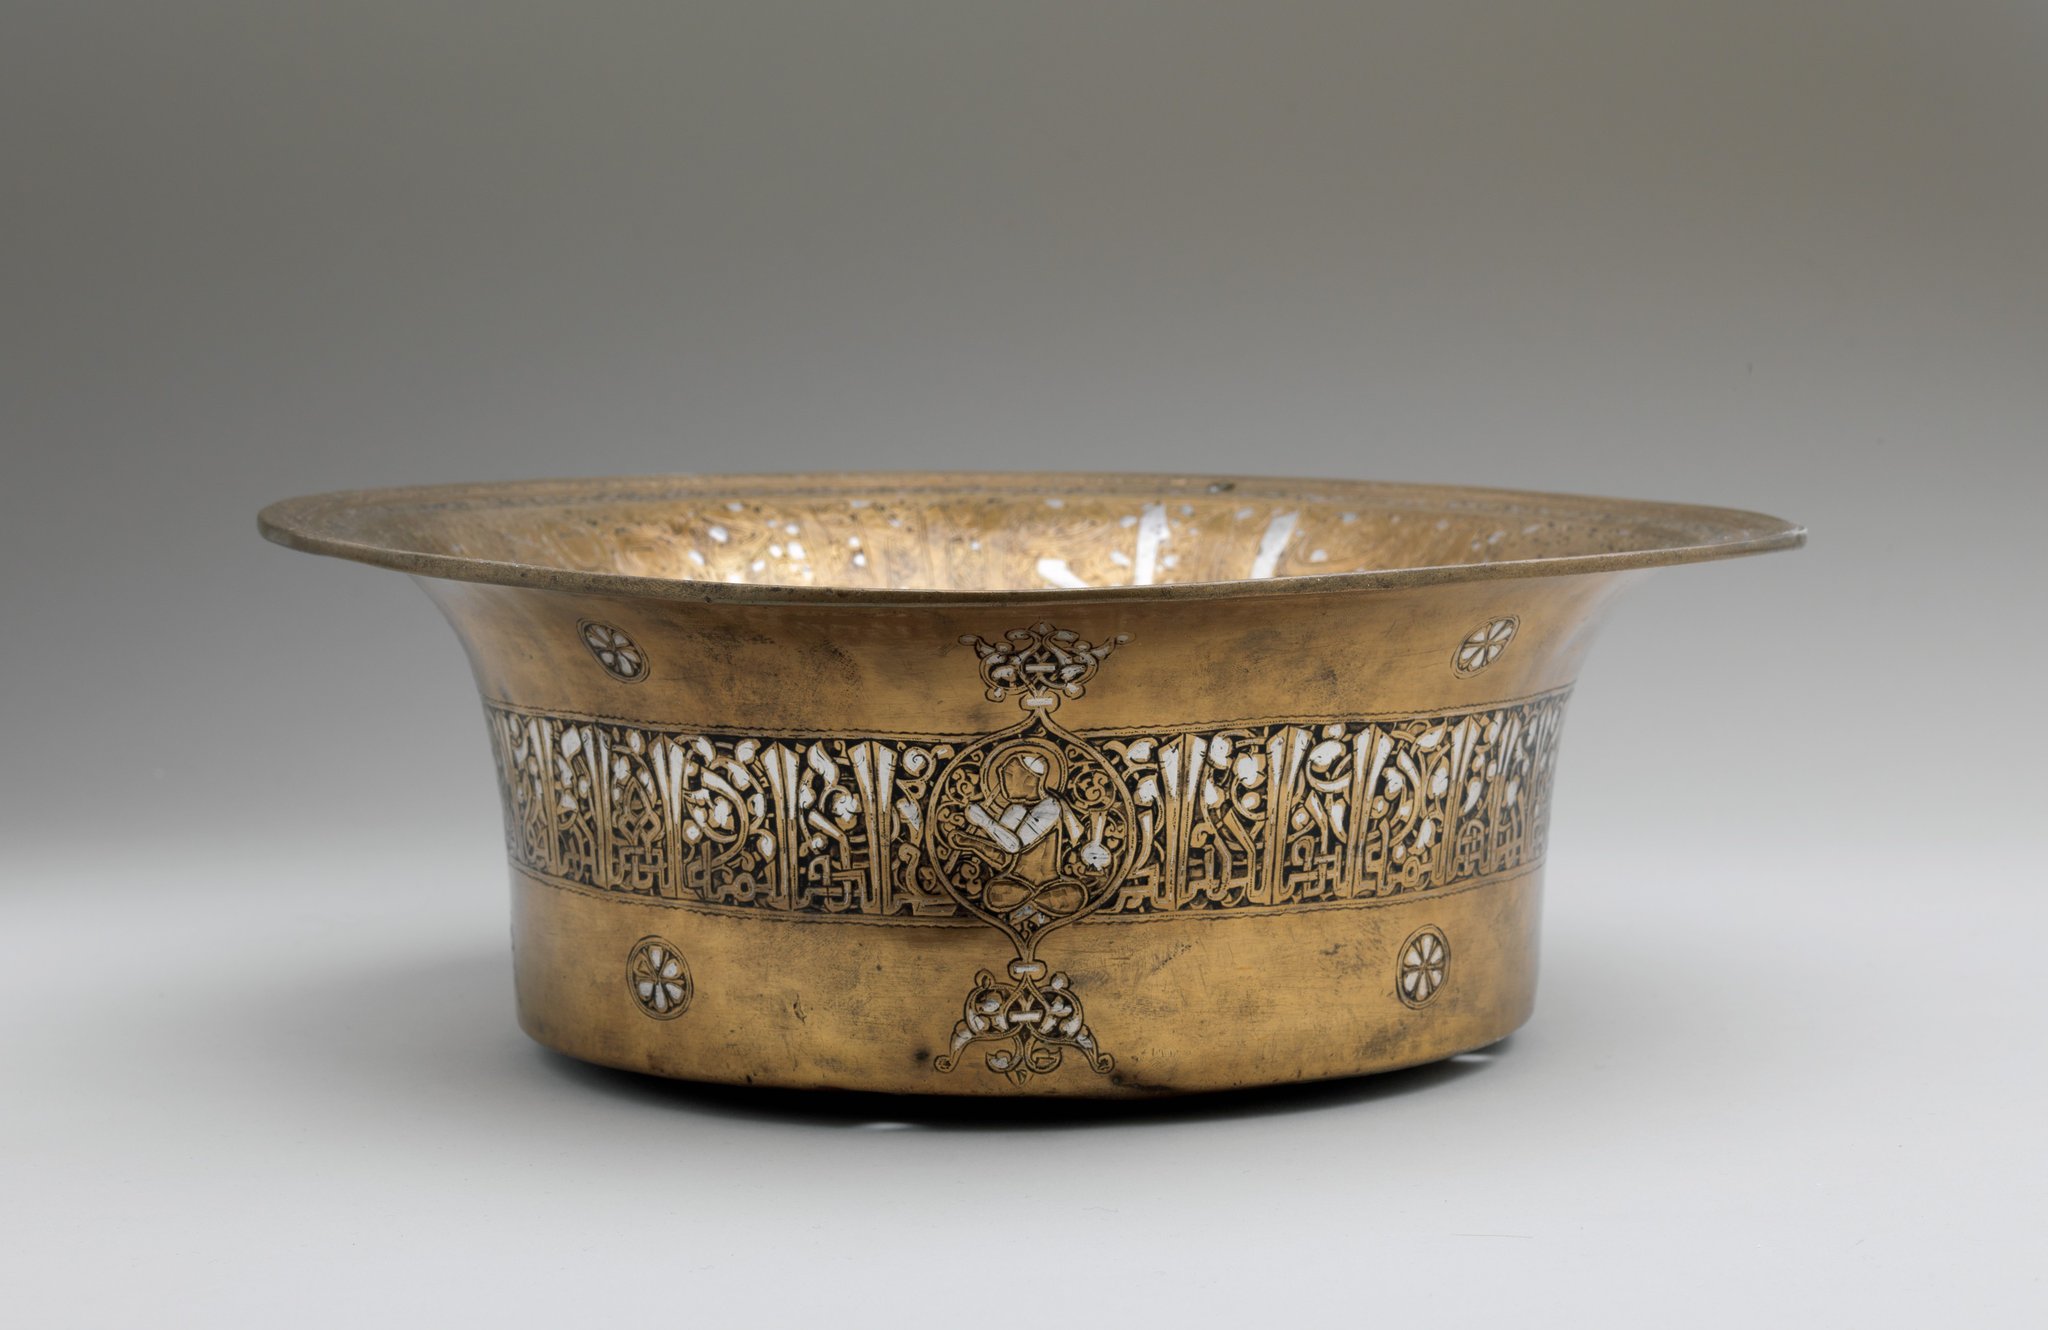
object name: basin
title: Basin with Zodiac Signs and Royal Titles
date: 1267-1333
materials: brass, silver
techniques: engraving, inlay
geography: egypt or syria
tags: arabic,zodiac